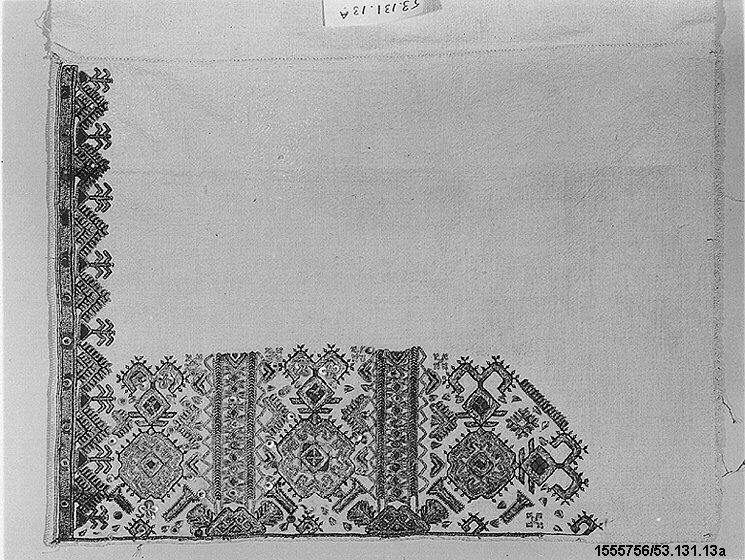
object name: sleeve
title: Pair of sleeves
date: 1801-1900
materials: cotton, metal thread, wool